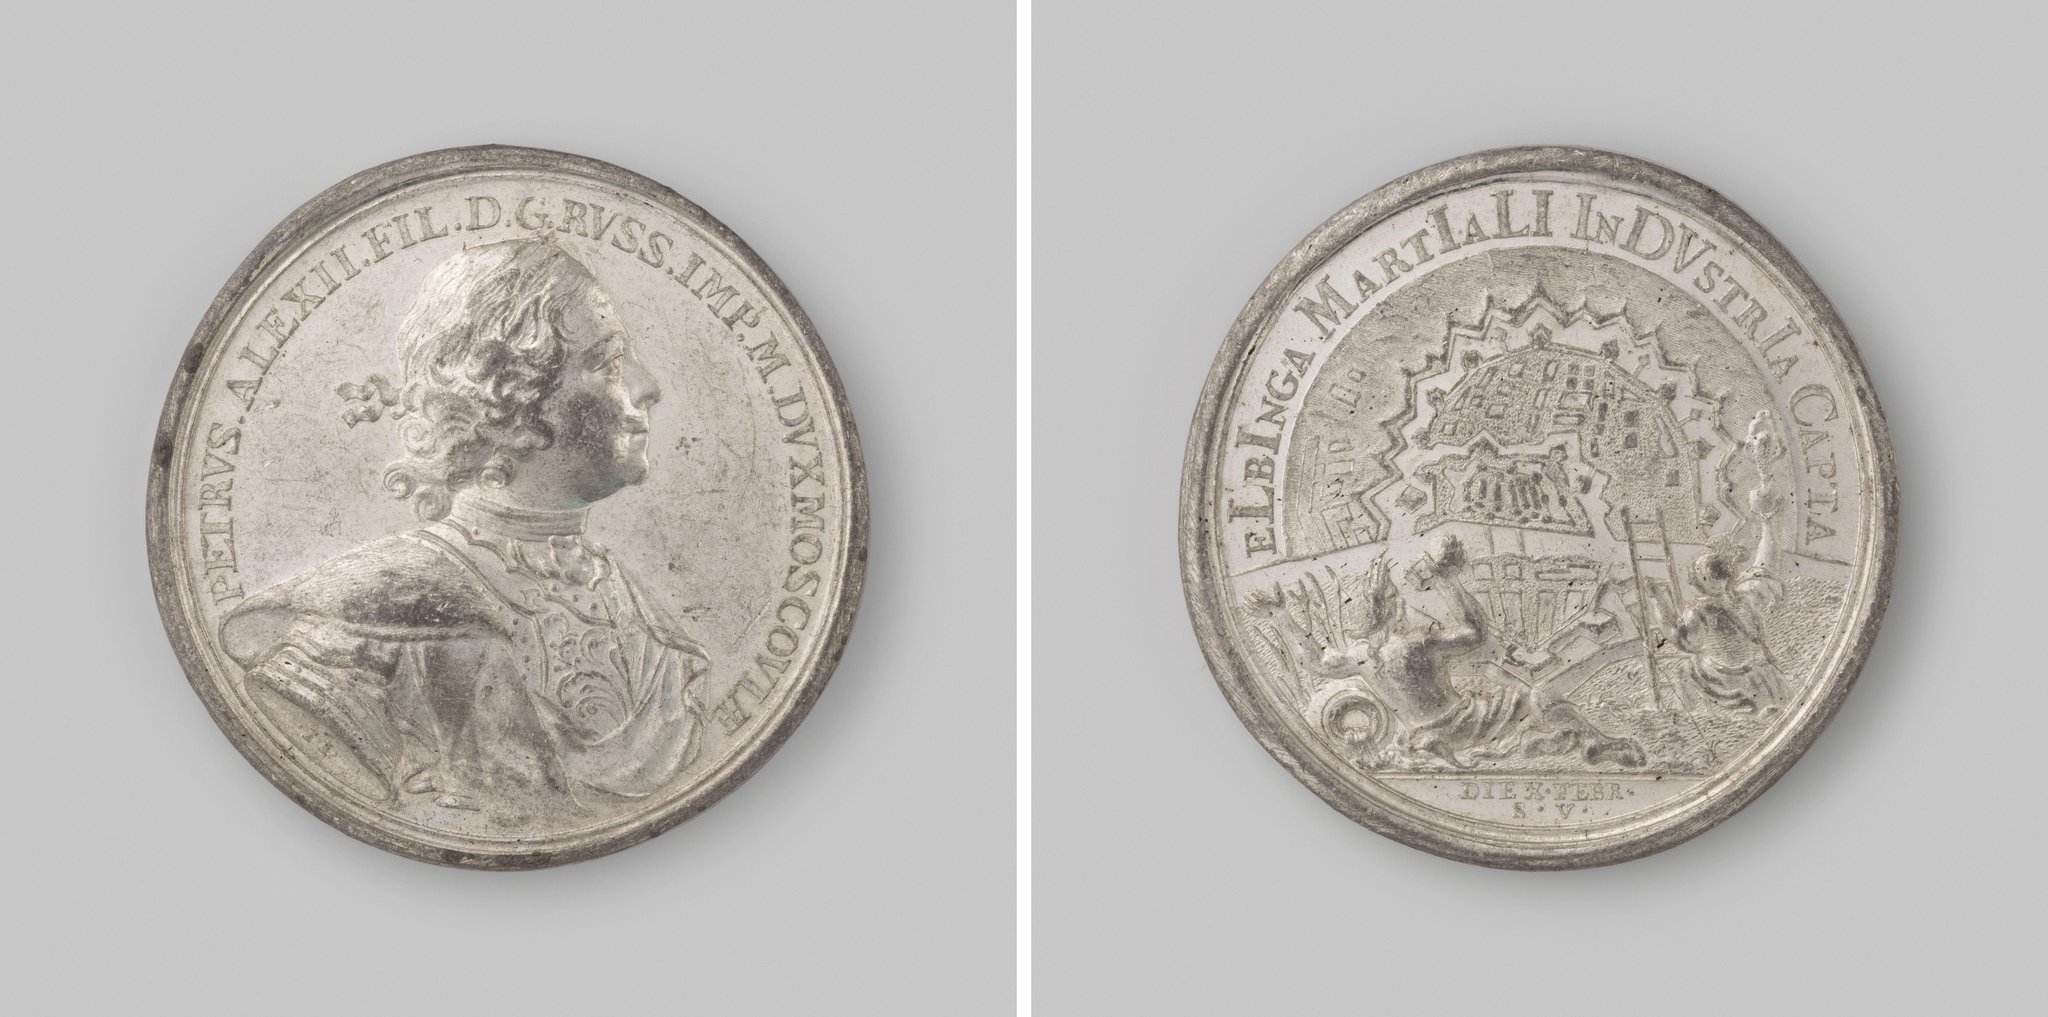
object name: history medal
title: Inname van Elbing door Rusland op Zweden 1710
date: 1710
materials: tin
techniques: striking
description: Tinnen penning, op de voorzijde het borstbeeld van Tsaar Peter de Grote naar rechts met omschrift, op de keerzijde een granaatwerpend soldaat met links een riviergod, op de achtergrond de plattegrond van Elbing, met omschrift en afsnedetekst.